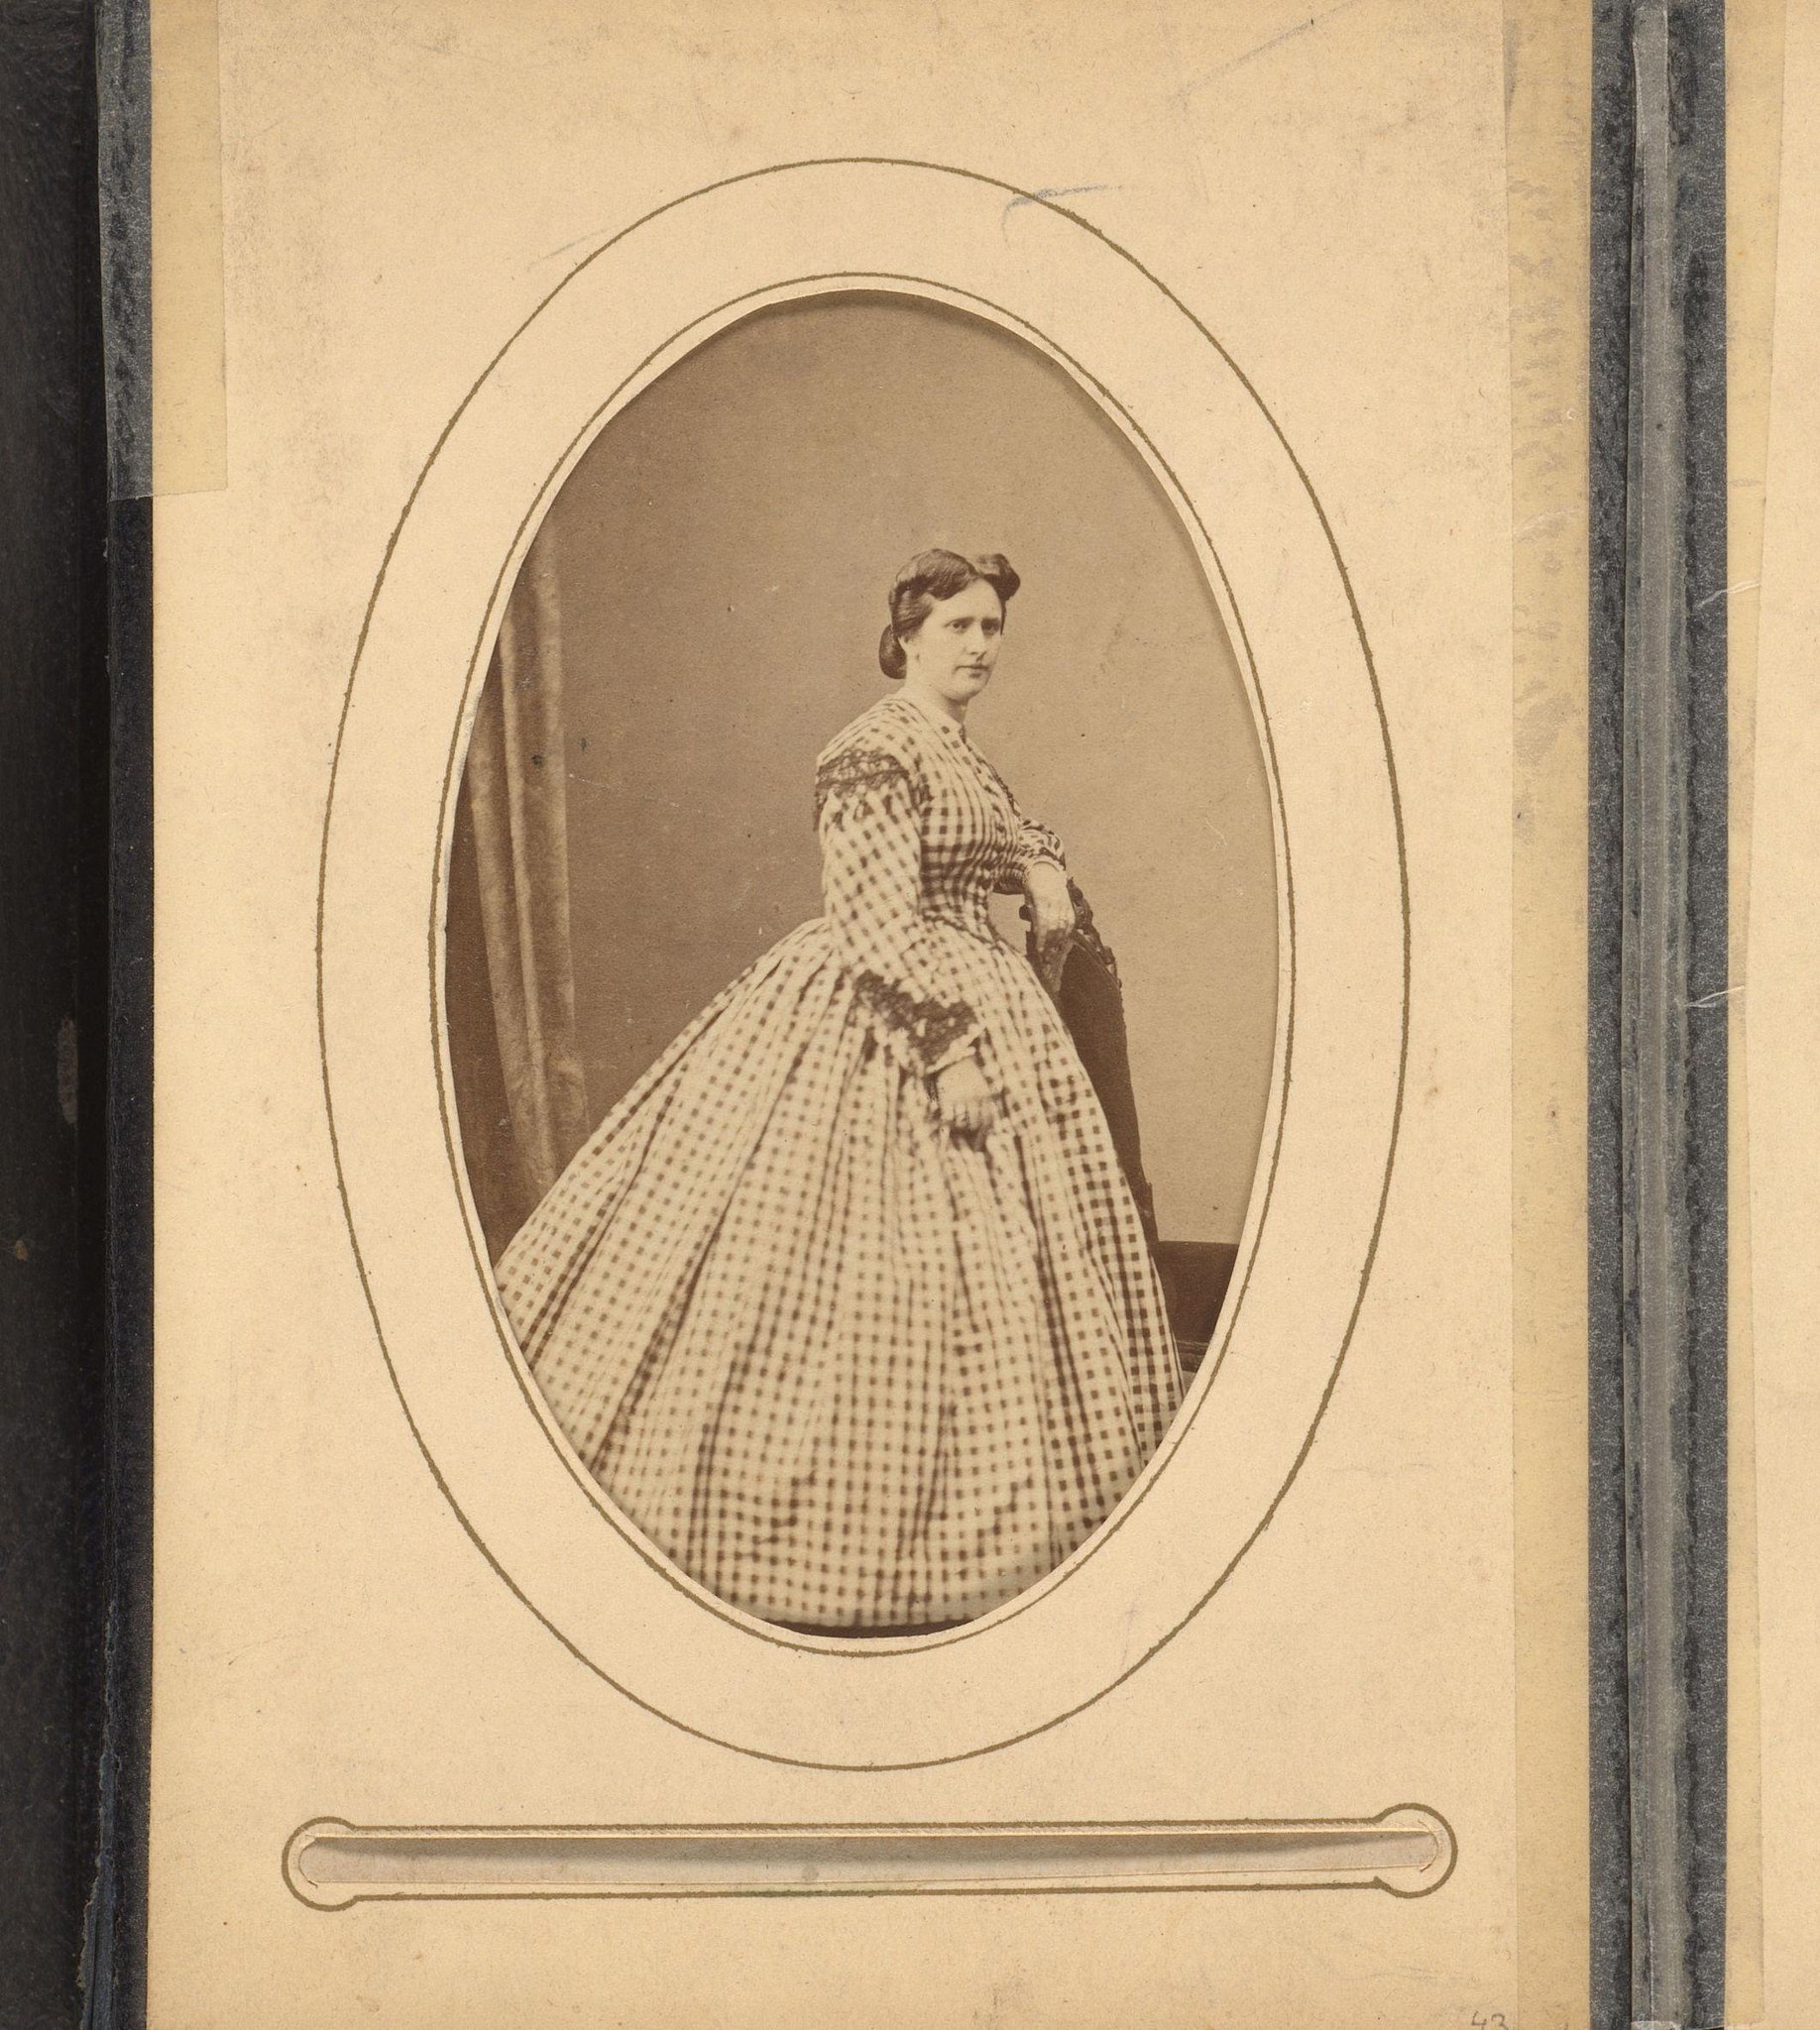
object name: album leaf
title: Portret van een vrouw in geruite jurk, staand bij een stoel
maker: johannes baer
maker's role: fotograaf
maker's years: 1840-1912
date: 1863-1906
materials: cardboard, photographic support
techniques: albumen print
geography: rotterdam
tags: historical persons - bb - woman, standing figure - aa - female human figure, chair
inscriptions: inscription: ‘J. Baer/ PHOTOGRAPHE/ ROTTERDAM.’